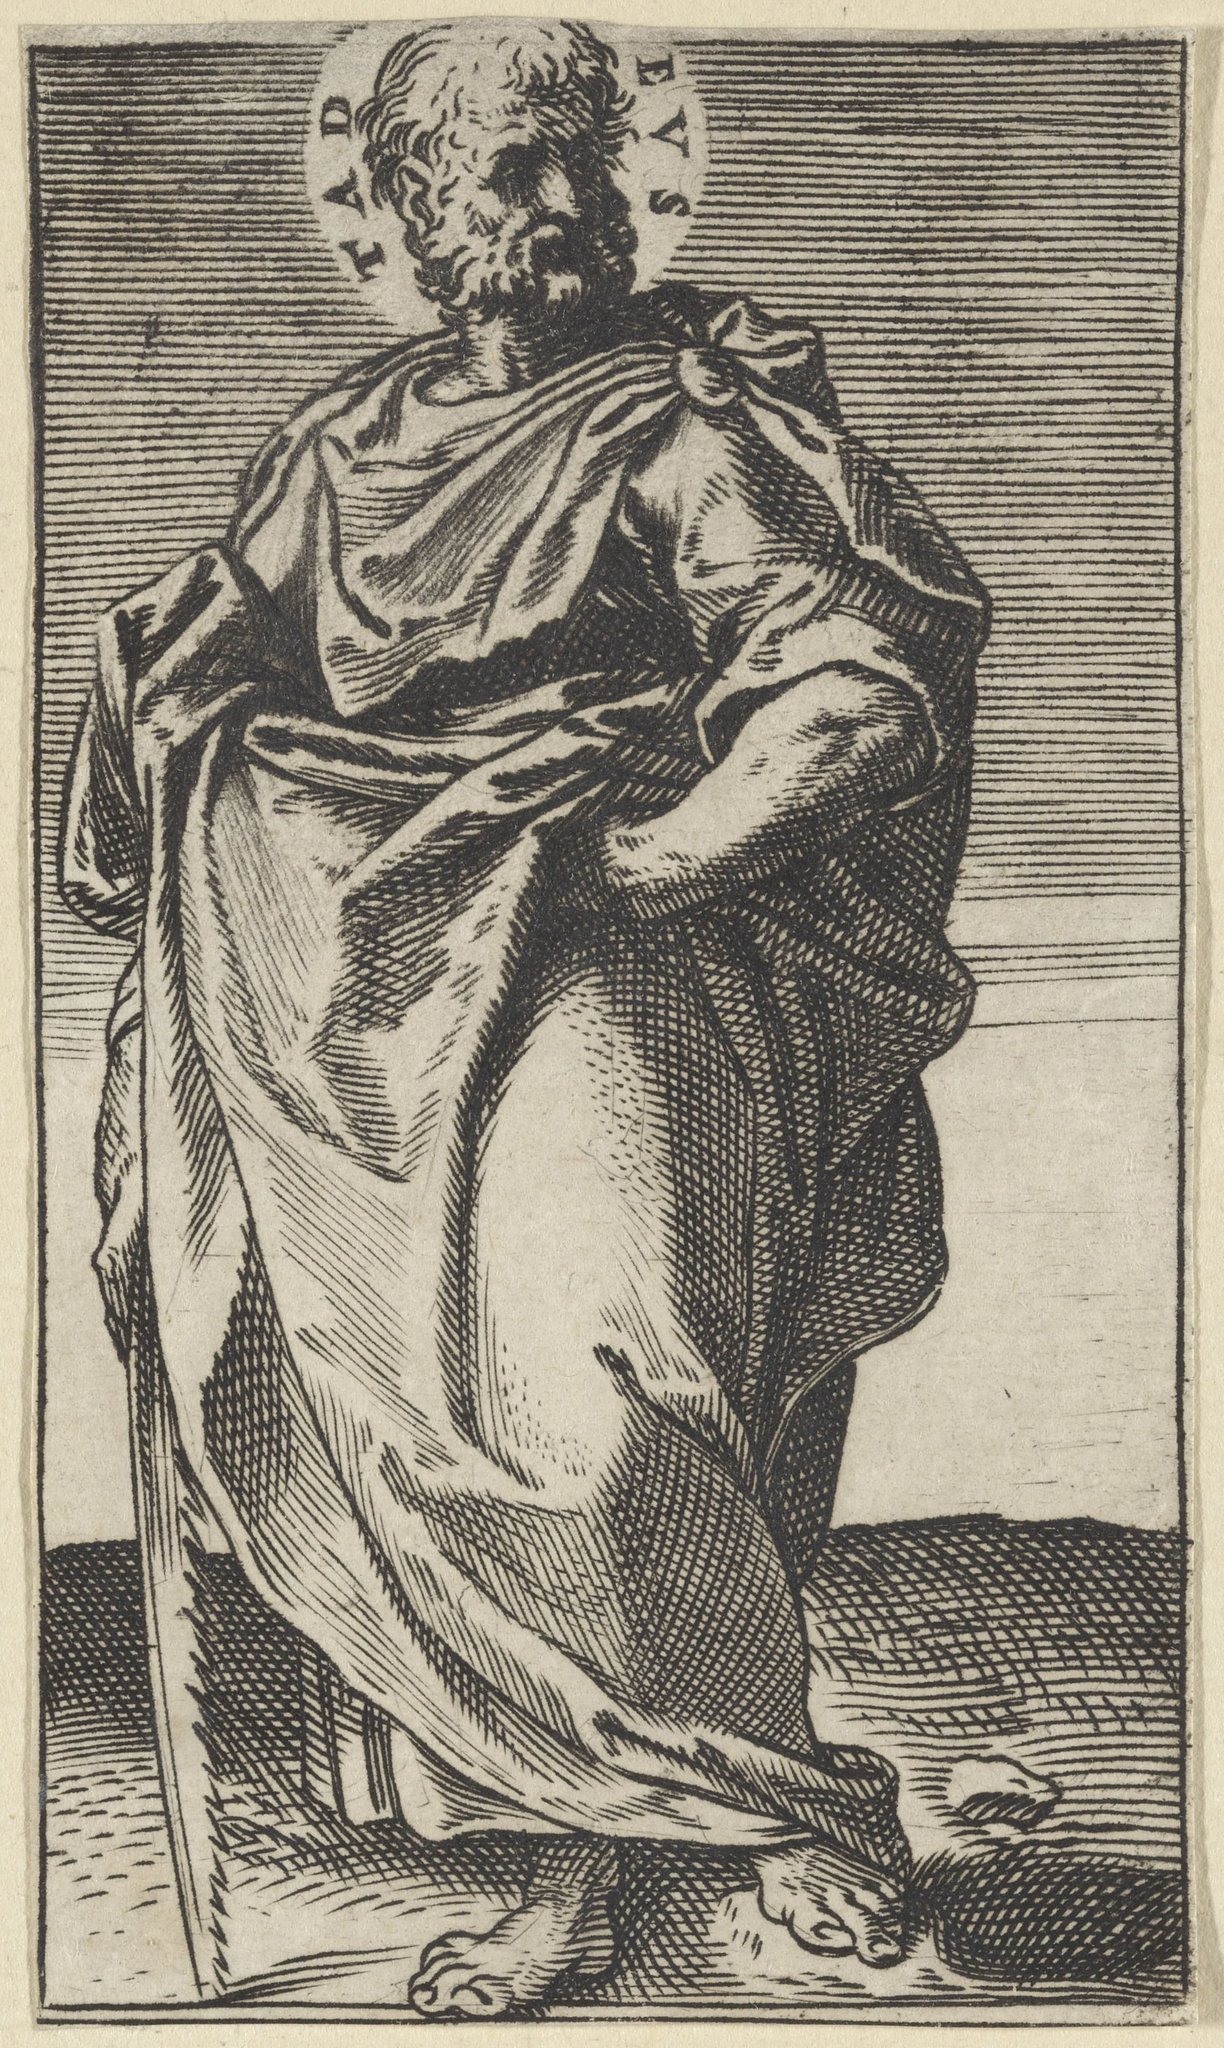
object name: print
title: Apostel Judas Taddeüs met een zaag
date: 1583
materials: paper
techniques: engraving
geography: italy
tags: male saints (judas)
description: Afbeelding gesneden uit een blad met drie voorstellingen van de apostelen Simon met een staf, Filippus met boek en kruisstaf en Judas Taddeüs met een zaag.